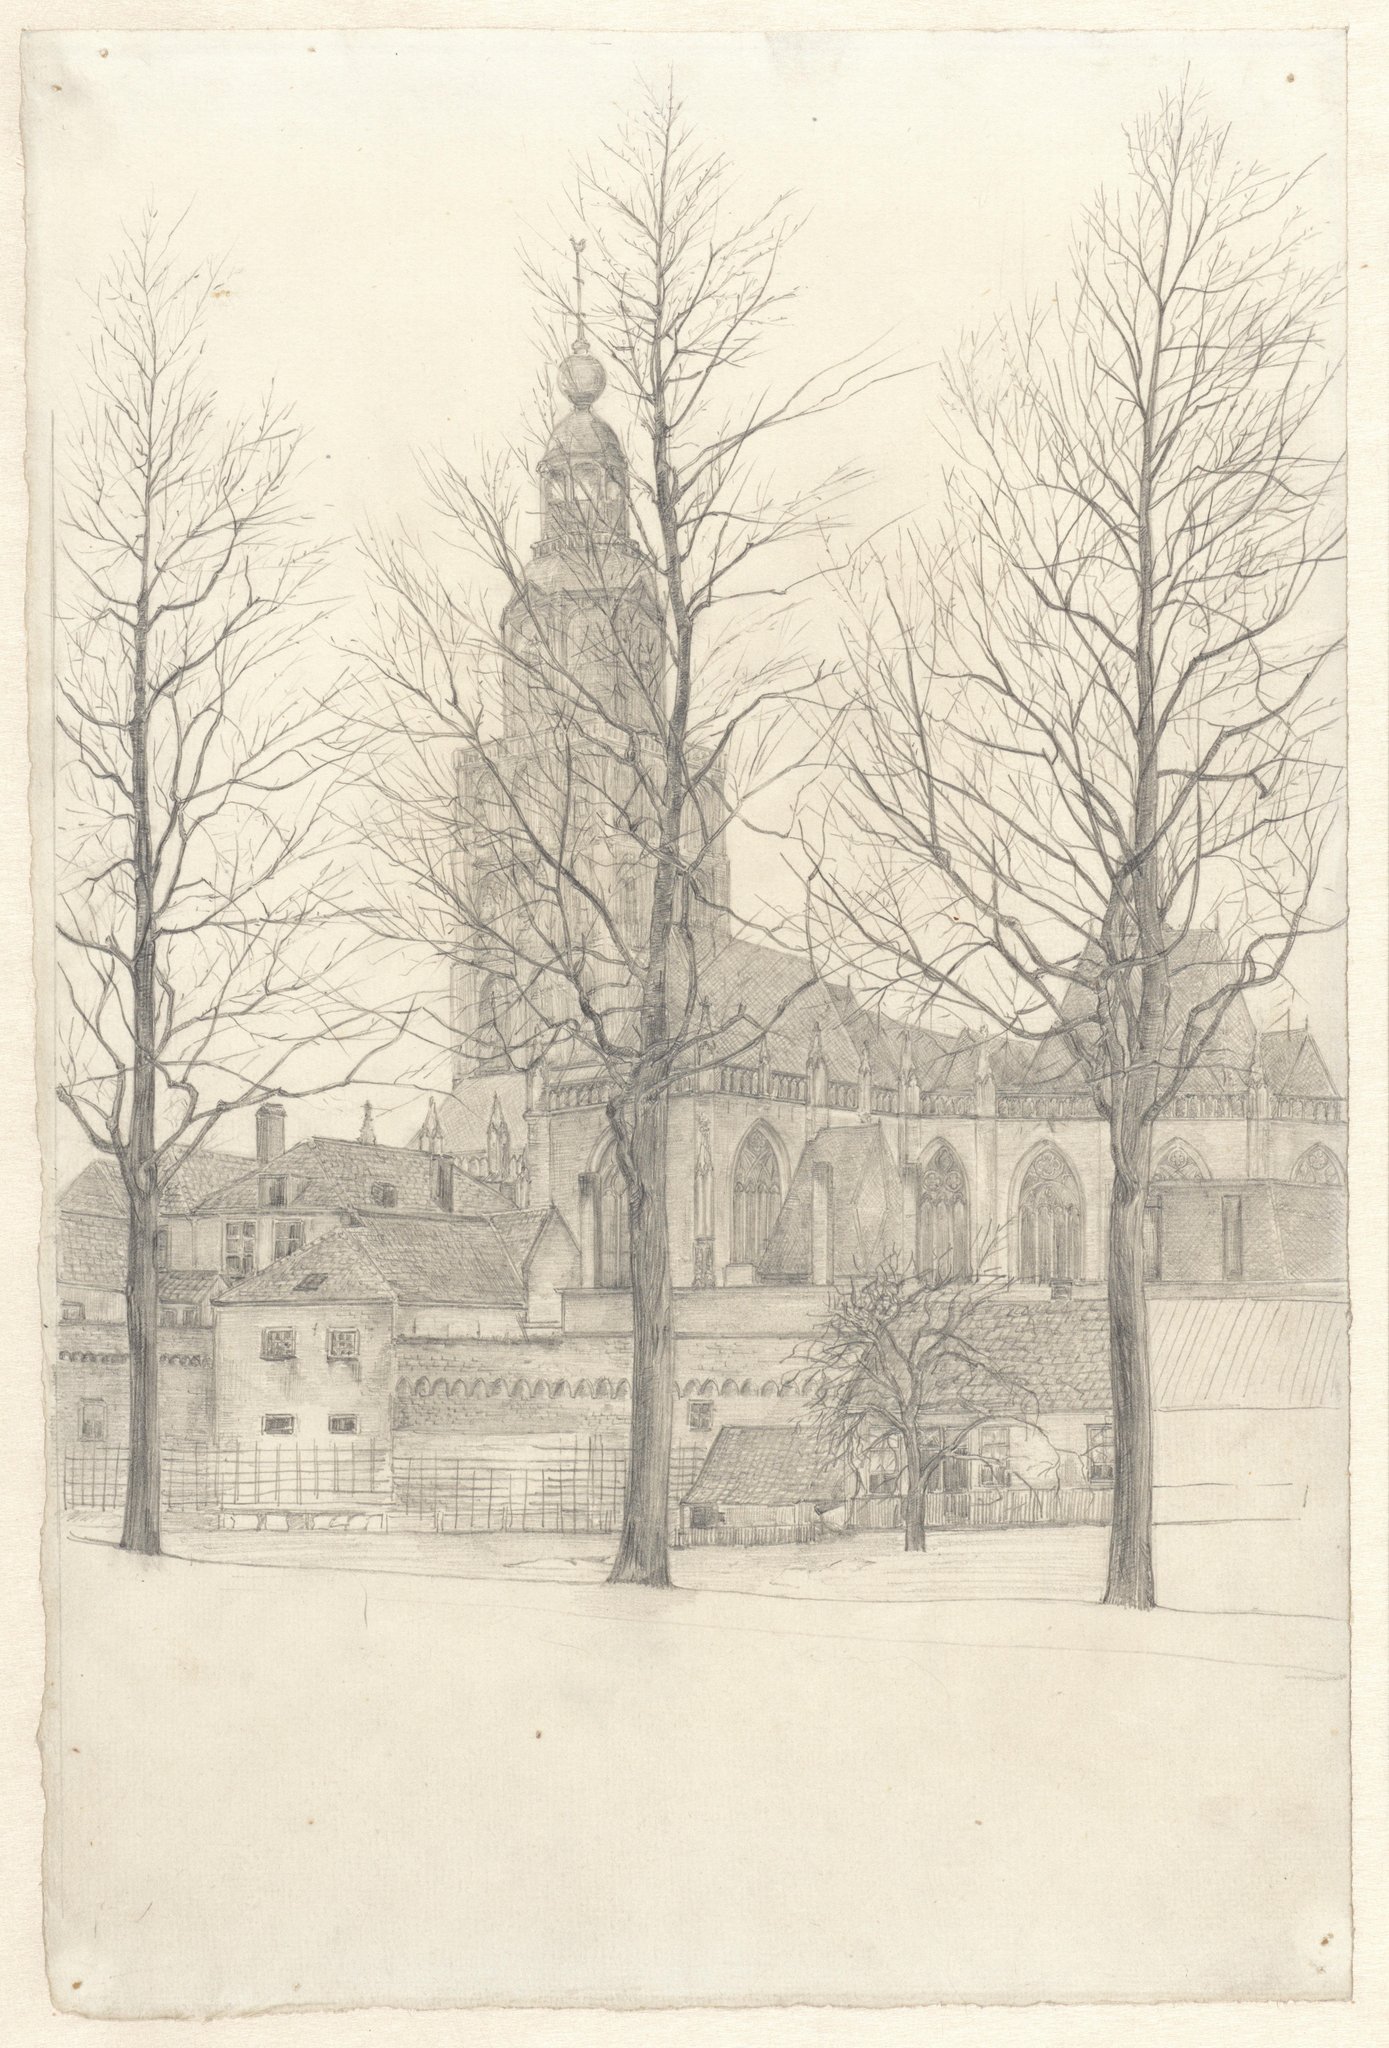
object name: drawing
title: Sint Walburgskerk te Zutphen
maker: johanna quirina van regteren altena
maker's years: 1876-1954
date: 1886-1954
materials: paper, pencil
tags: church (exterior)